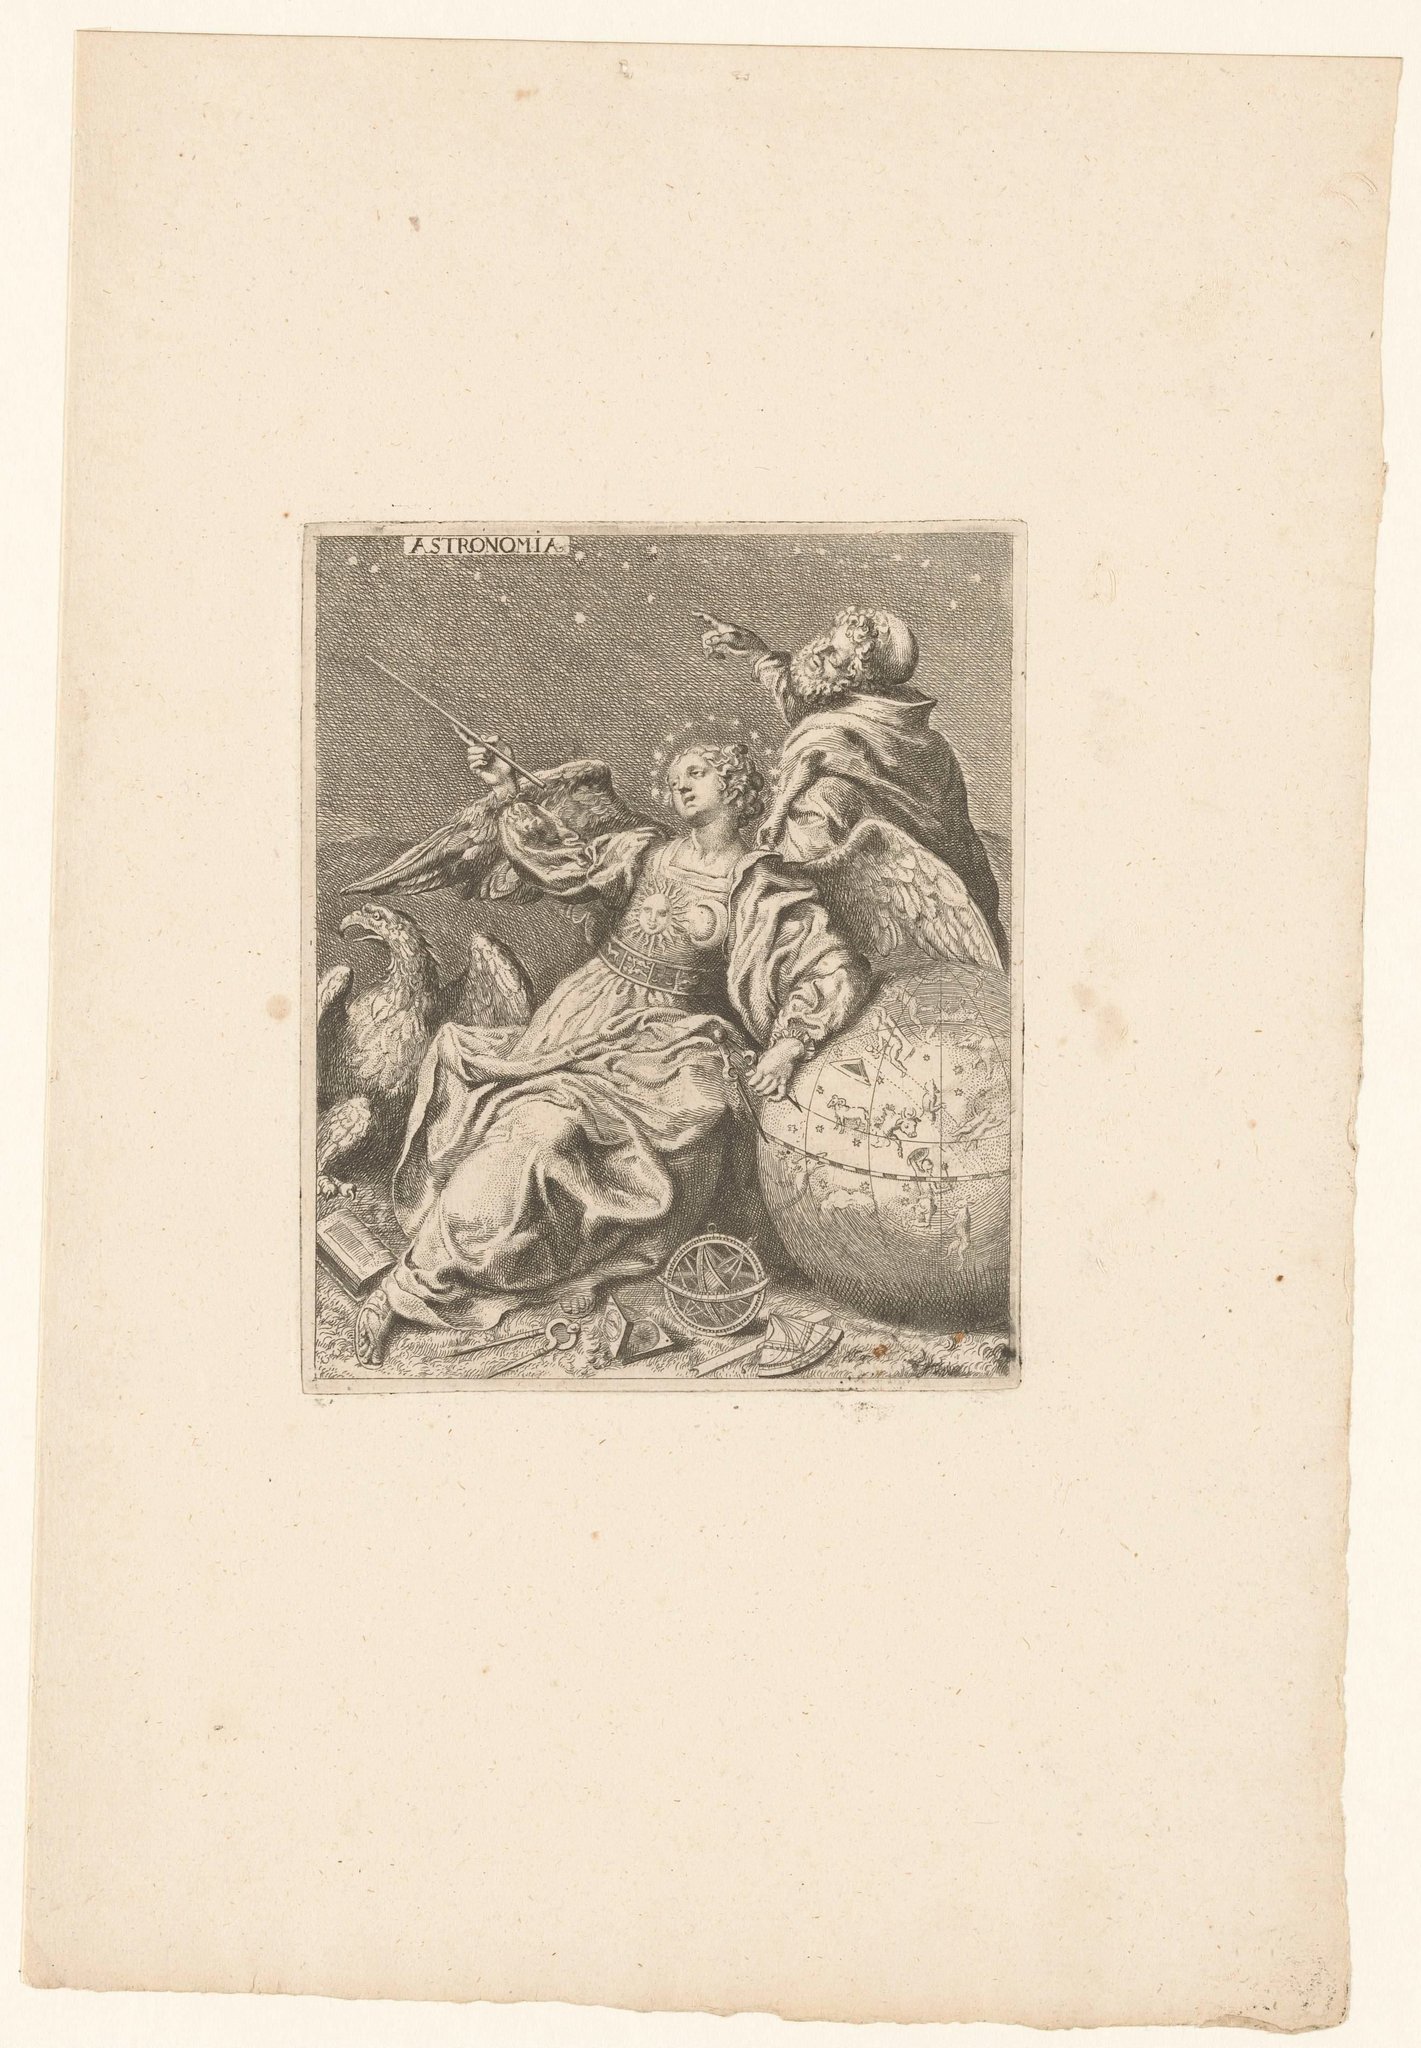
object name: print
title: Septem Liberales Artes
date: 1645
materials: paper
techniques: etching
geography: london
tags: education, science and learning, the liberal arts, 'artes liberales', predatory birds: eagle, 'astronomia' (~ quadrivium); 'astronomia' (ripa), measuring-instruments, armillary sphere, skeleton celestial globe, stars in the firmament, star-globe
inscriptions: collector's mark: Lugt 2228, collector's mark: Lugt 2760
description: Onderdeel van een serie van zeven prenten en een titelprent.